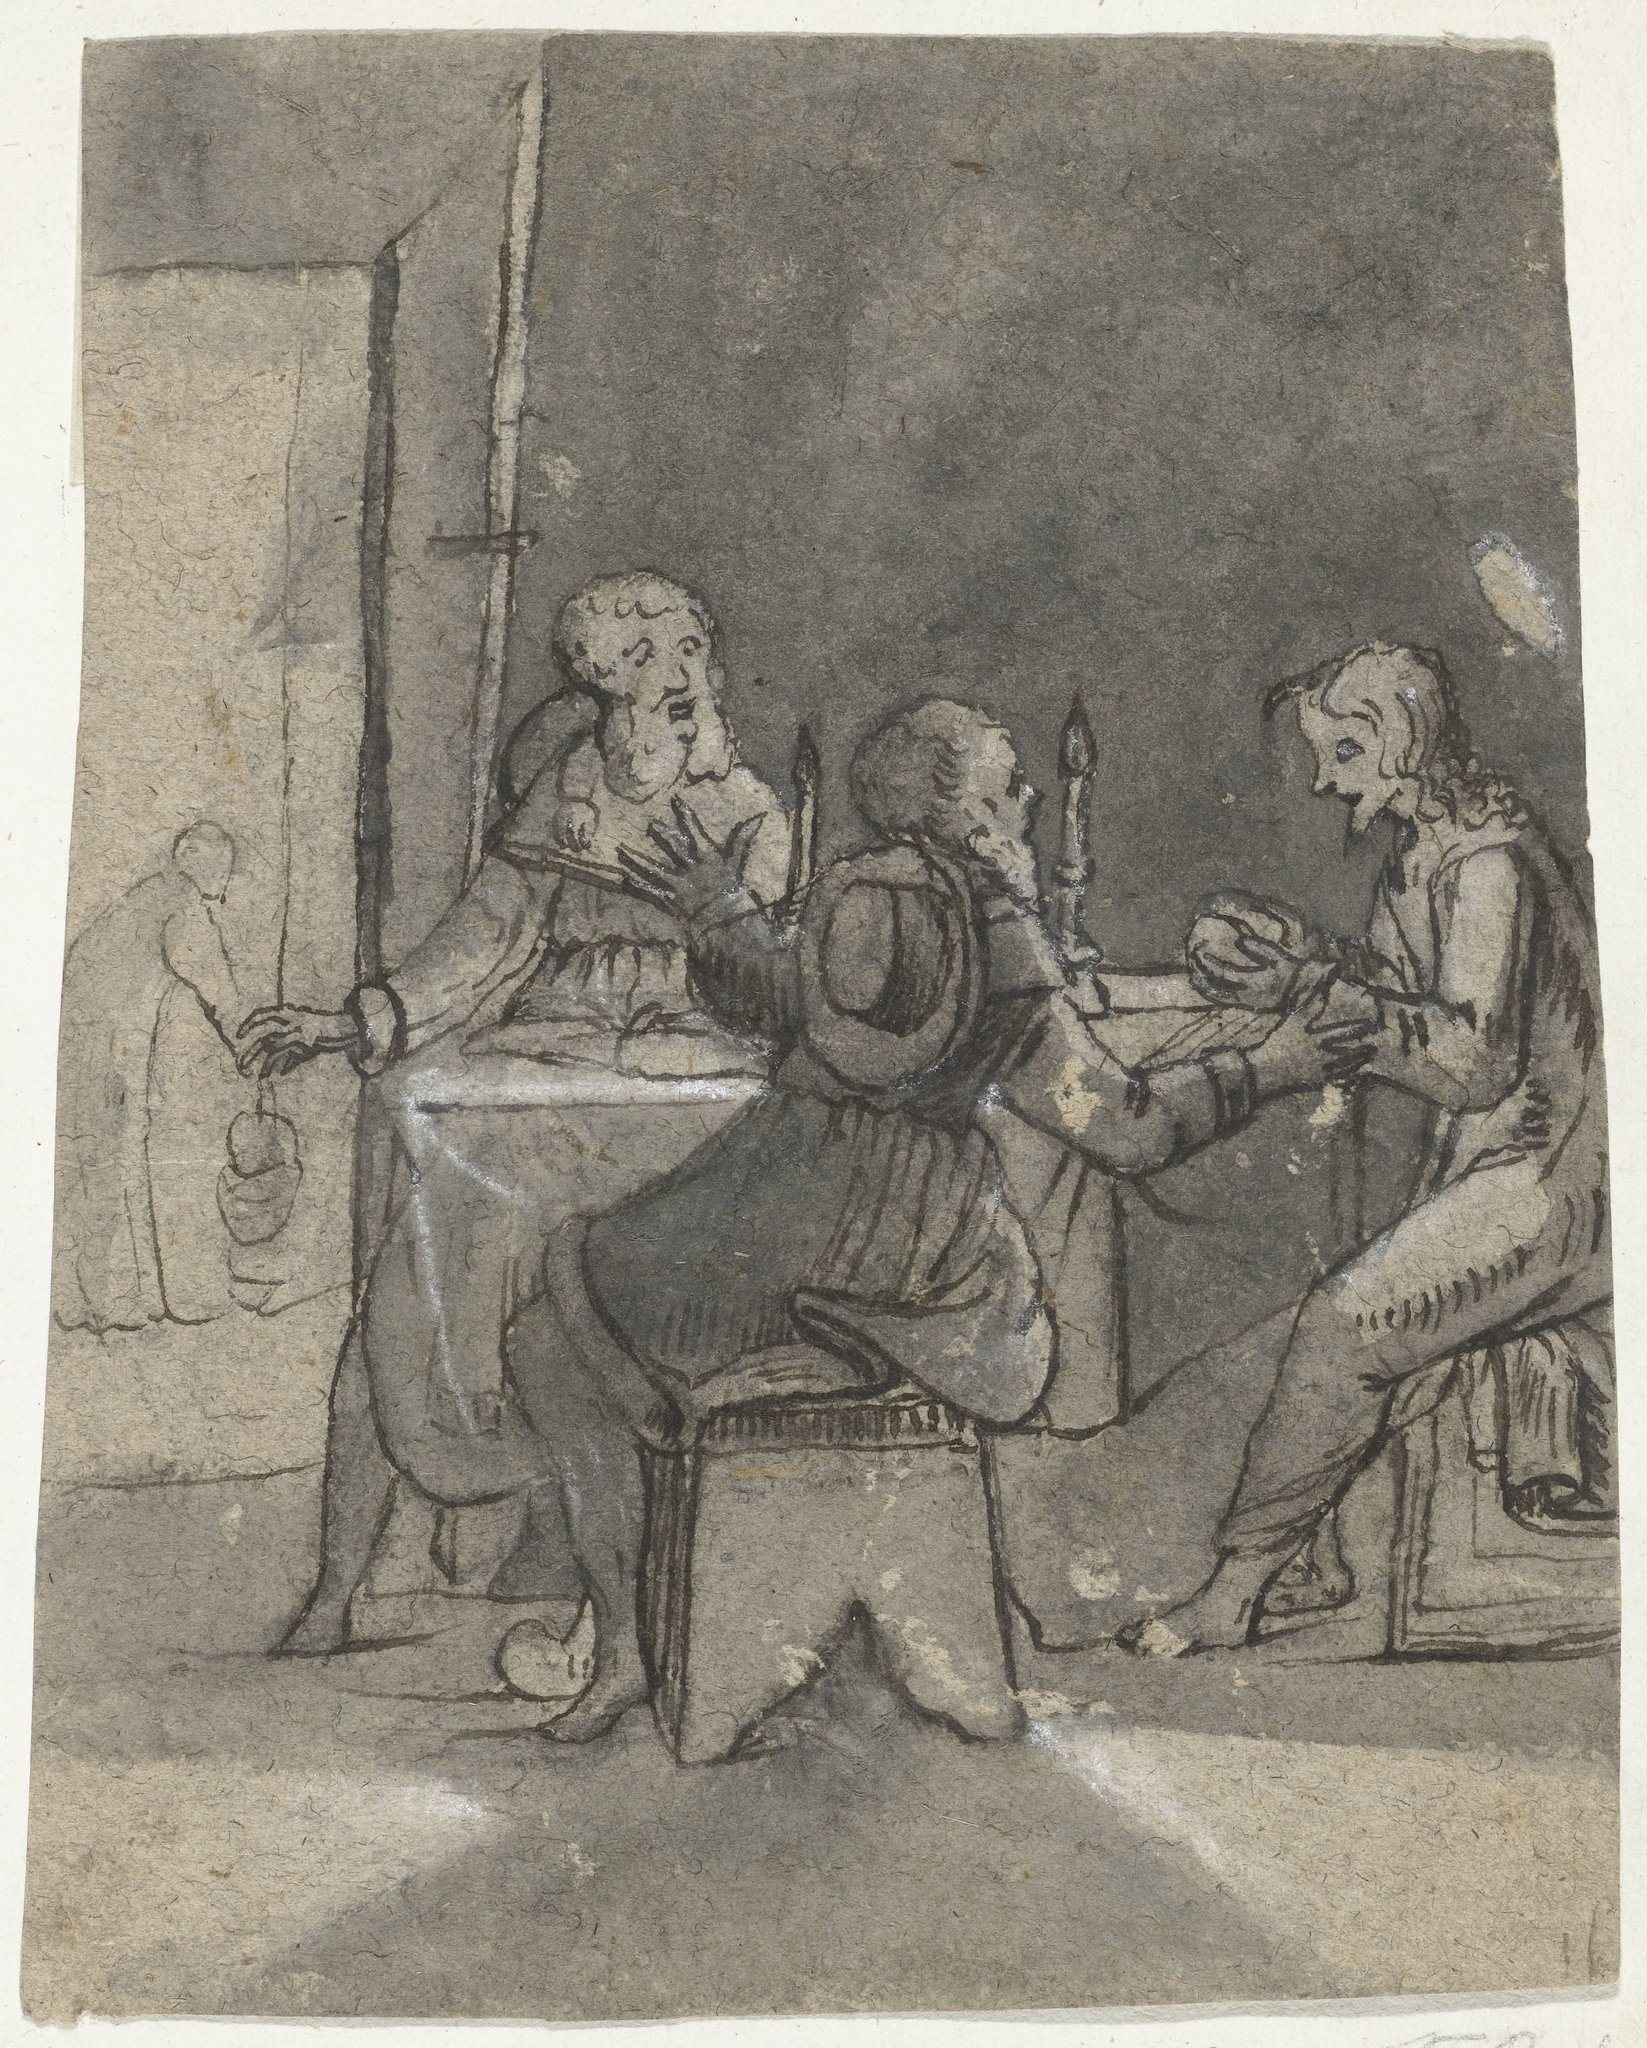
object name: drawing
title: Maaltijd te Emmaüs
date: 1617-1677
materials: paint, ink, paper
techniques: brush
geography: zwolle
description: Tekening naast een andere tekening opgeplakt in het Familie-plakboek. Kopie naar Maaltijd te Emmaüs van Gerard ter Borch uit 1617 (BI-1887-1463-131(R)).